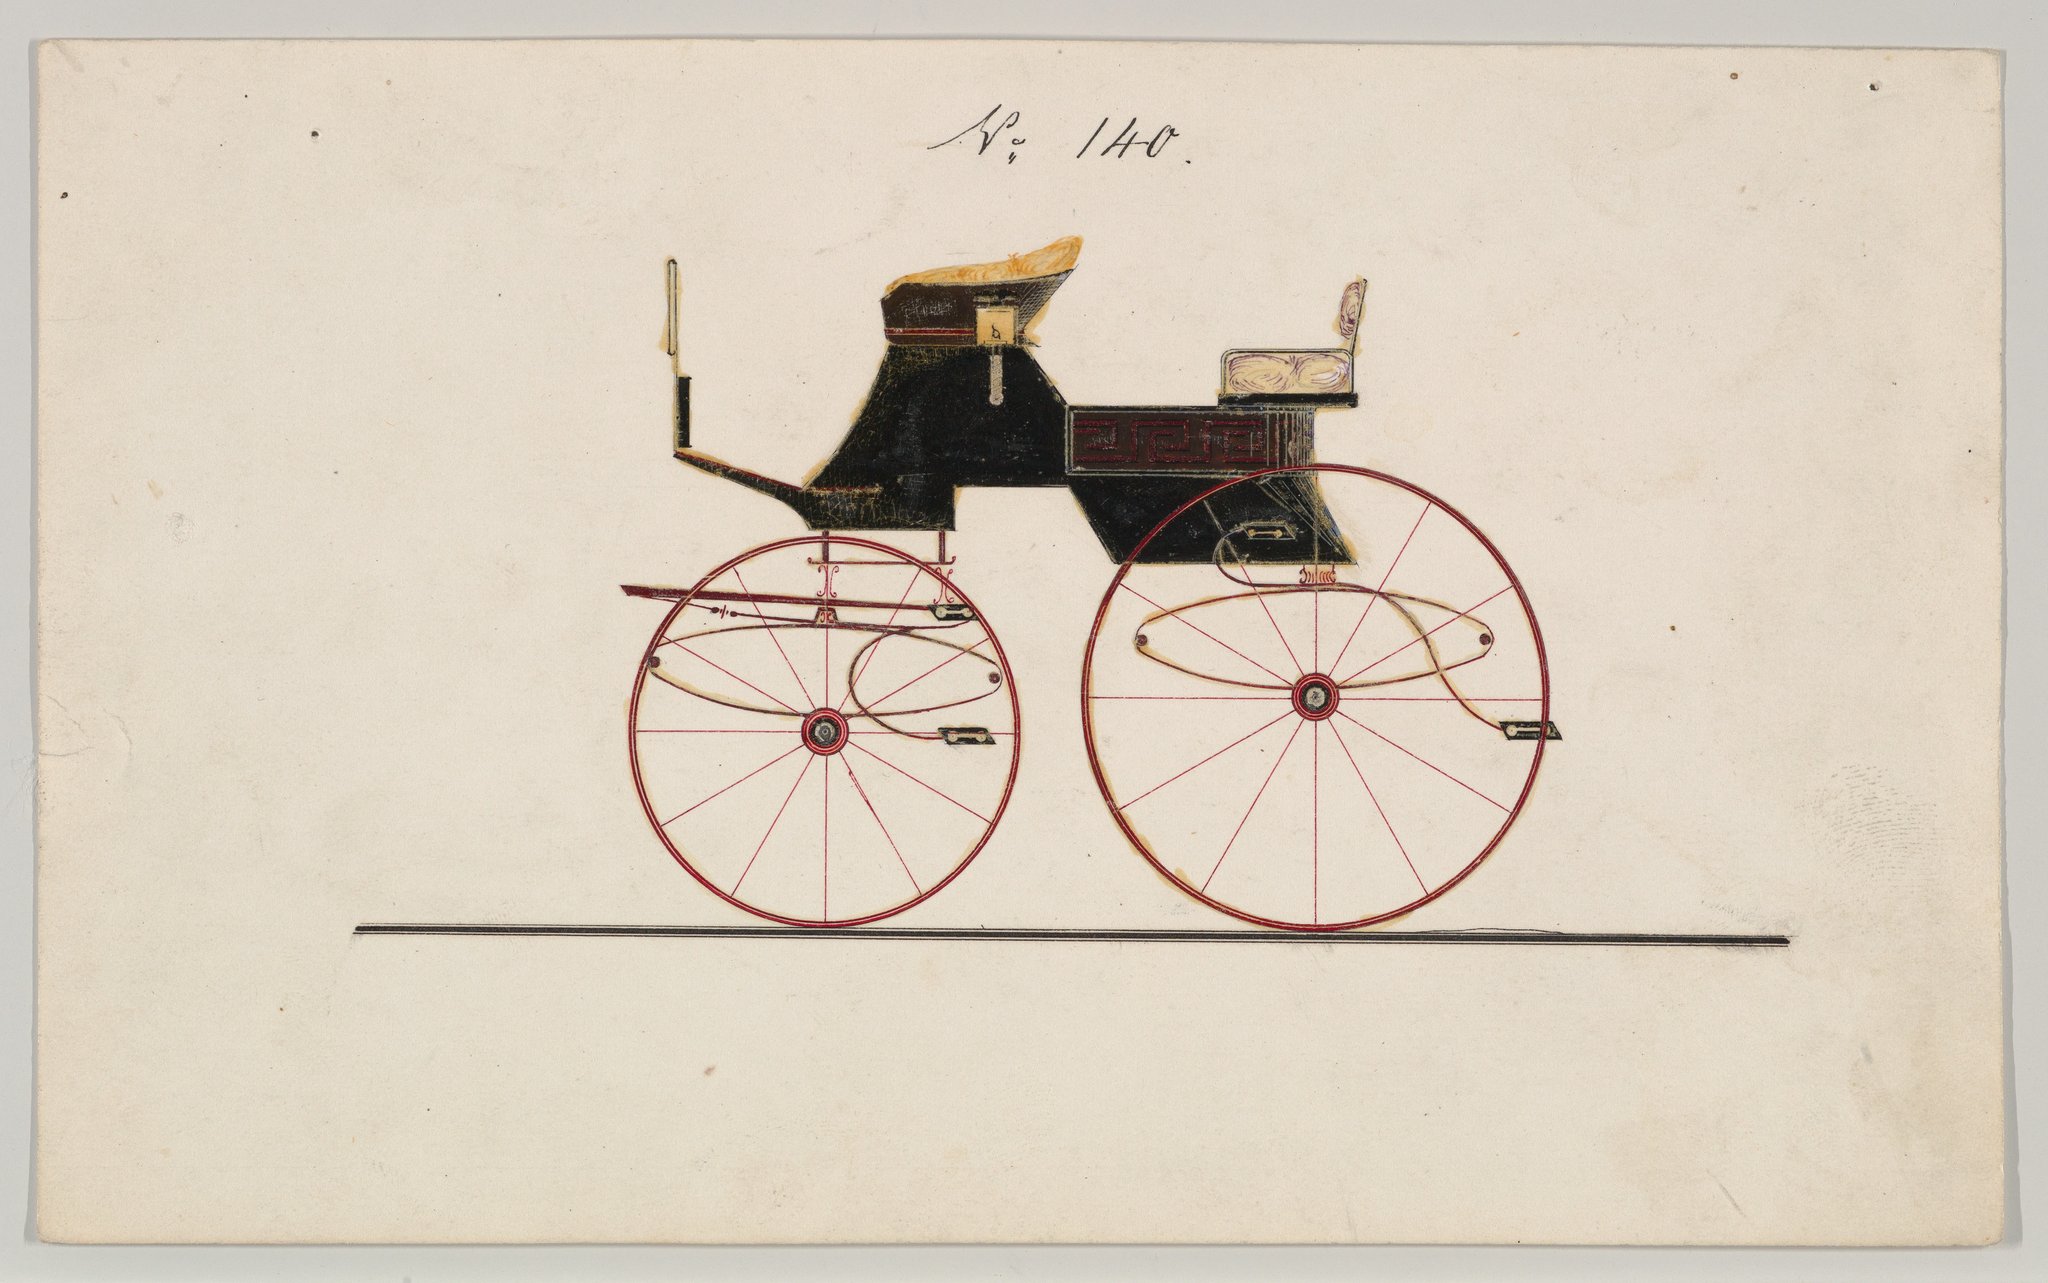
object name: drawing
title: Dog Cart Phaeton #140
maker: brewster & co.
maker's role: manufacturer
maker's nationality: american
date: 1850-1870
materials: gouache, gum arabic, ink, watercolor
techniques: pen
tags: carriages